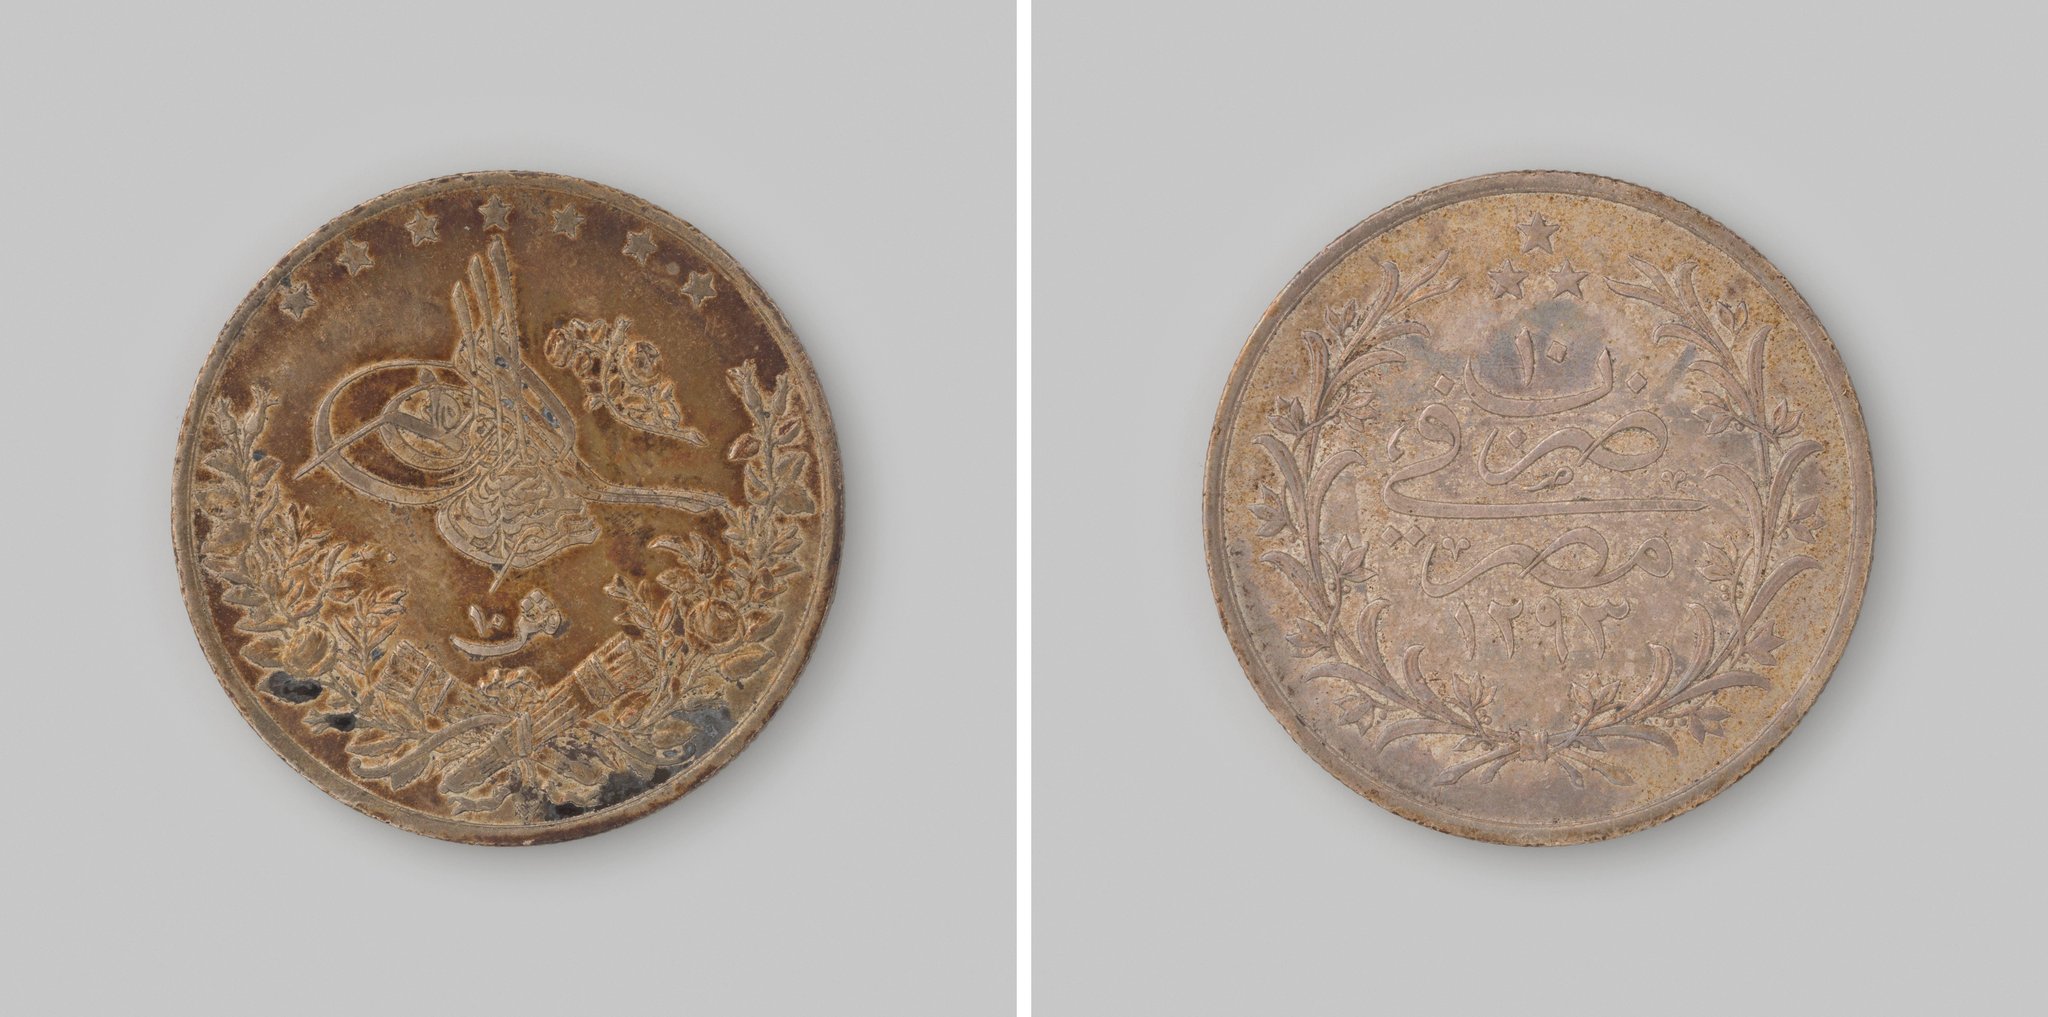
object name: coin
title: 10 qirsh uit Egypte van de Ottomaanse sultan Abdul Hamid II, regeringsjaar 10 [=1884]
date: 1884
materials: silver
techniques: striking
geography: cairo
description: Zilveren munt. Voorzijde: tussen twee met srtik samengebonden houders, waaruit takken, waarboven zeven sterren, tughra met rechts daarvan takje met bladeren. Onder de tughra in twee regels waarde-aanduiding:10 qirsh. Onder strik letter: W [=graveur Weigand]. Keerzijde: binnen twee samengebonden takken, waarboven drie sterren, drieregelig opschrift in Arabische letters met muntplaats-aanduiding: Misr [=Egypte]. Boven in opschrift regeringsjaar: 10. Onder muntplaats-aanduiding jaar van aantreden:1293 [=1875]. Kartelrand.